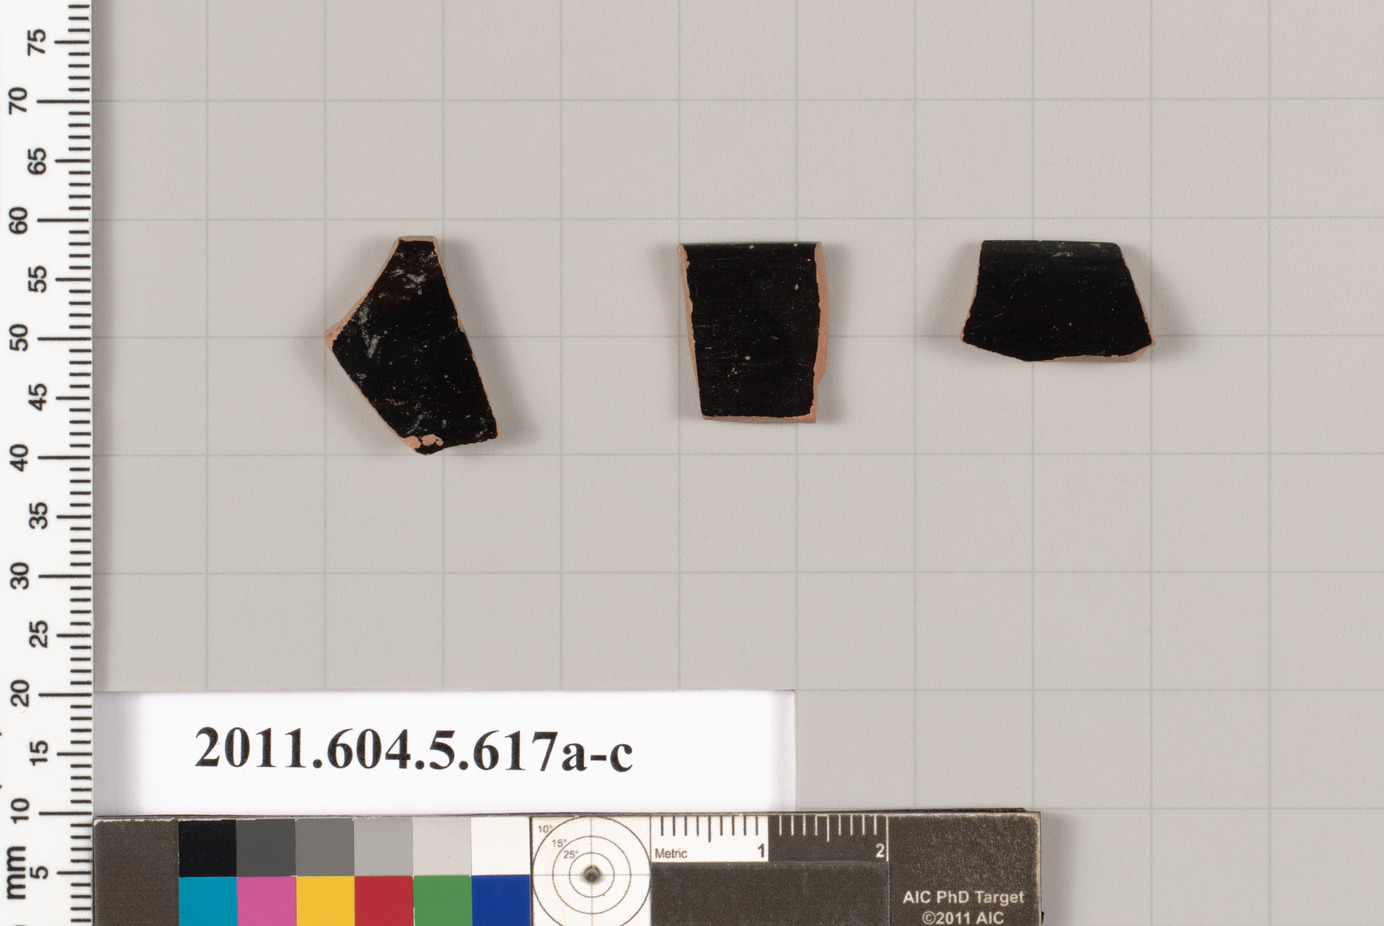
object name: kylix fragment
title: Terracotta rim fragments of kylikes (drinking cups)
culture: greek, attic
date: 600-401 BCE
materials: terracotta